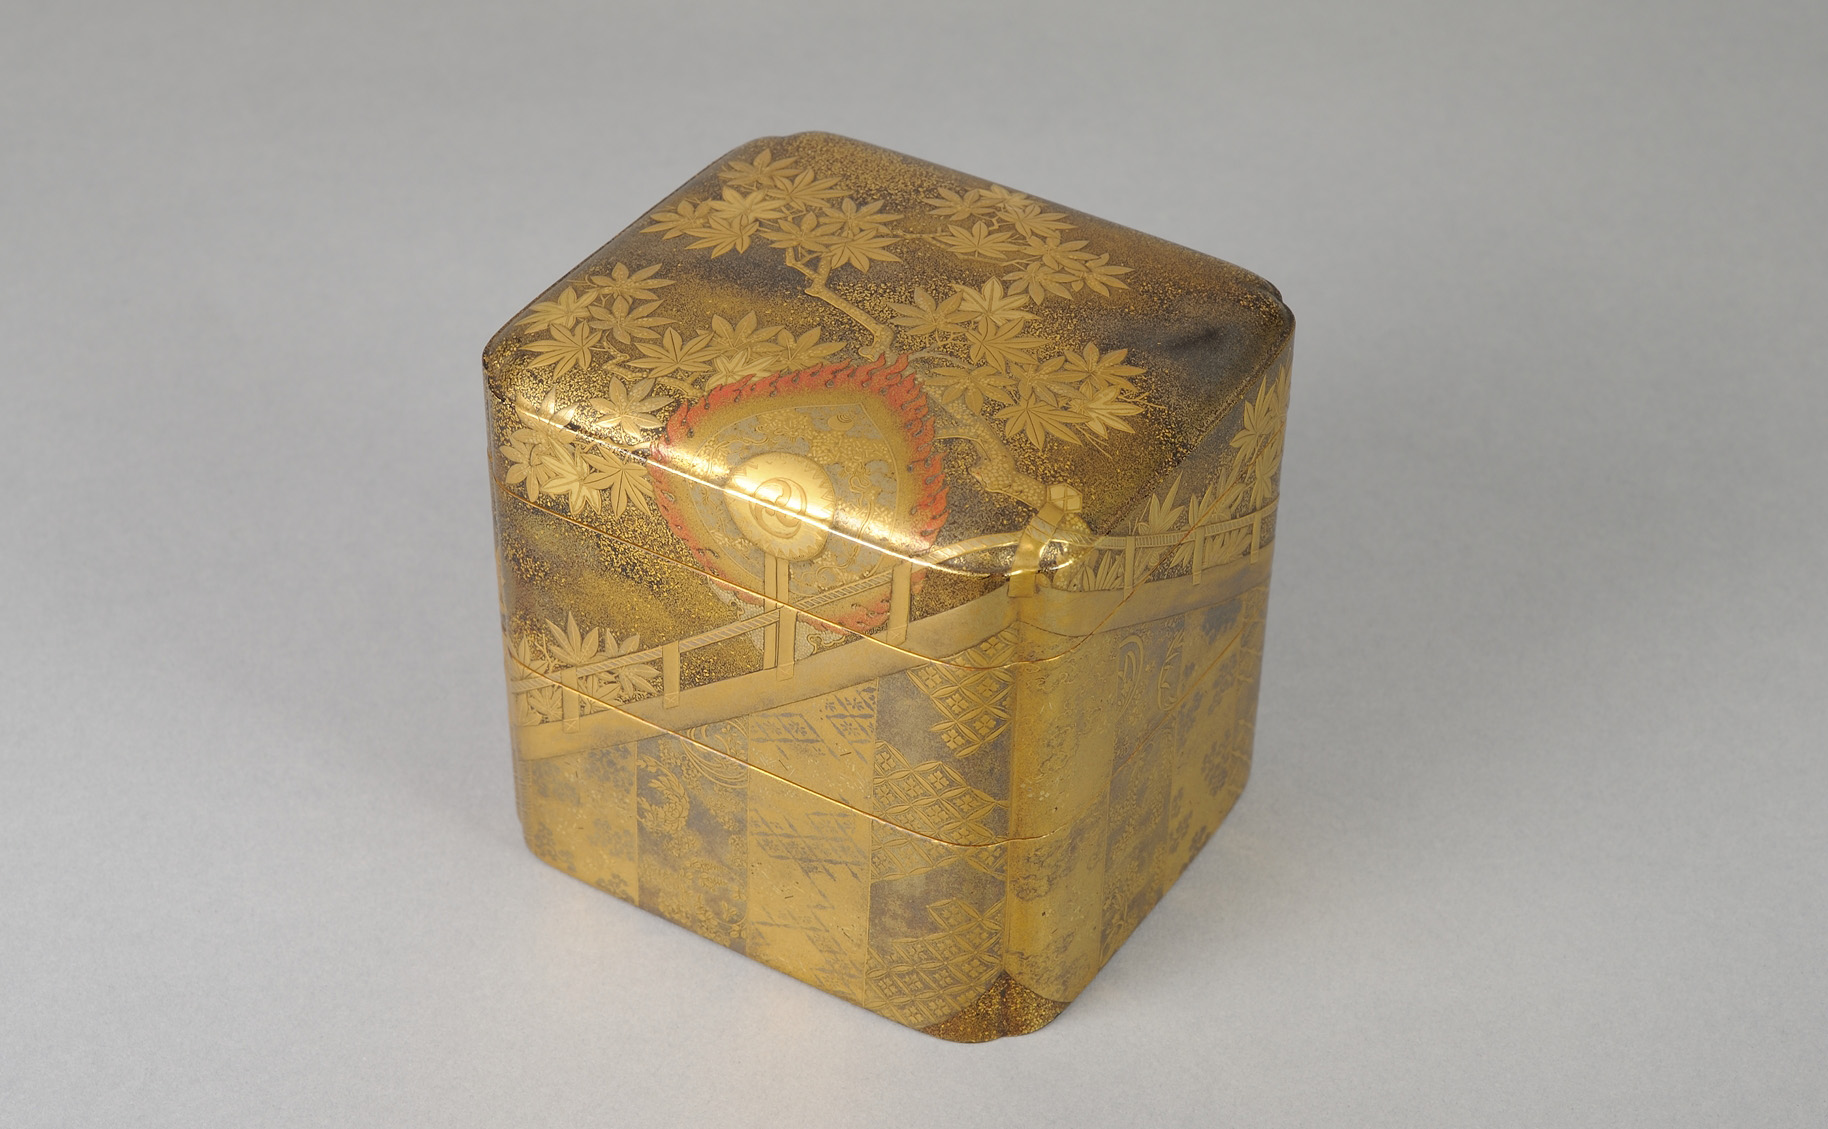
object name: incense box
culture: japanese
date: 1867-1900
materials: lacquer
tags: trees